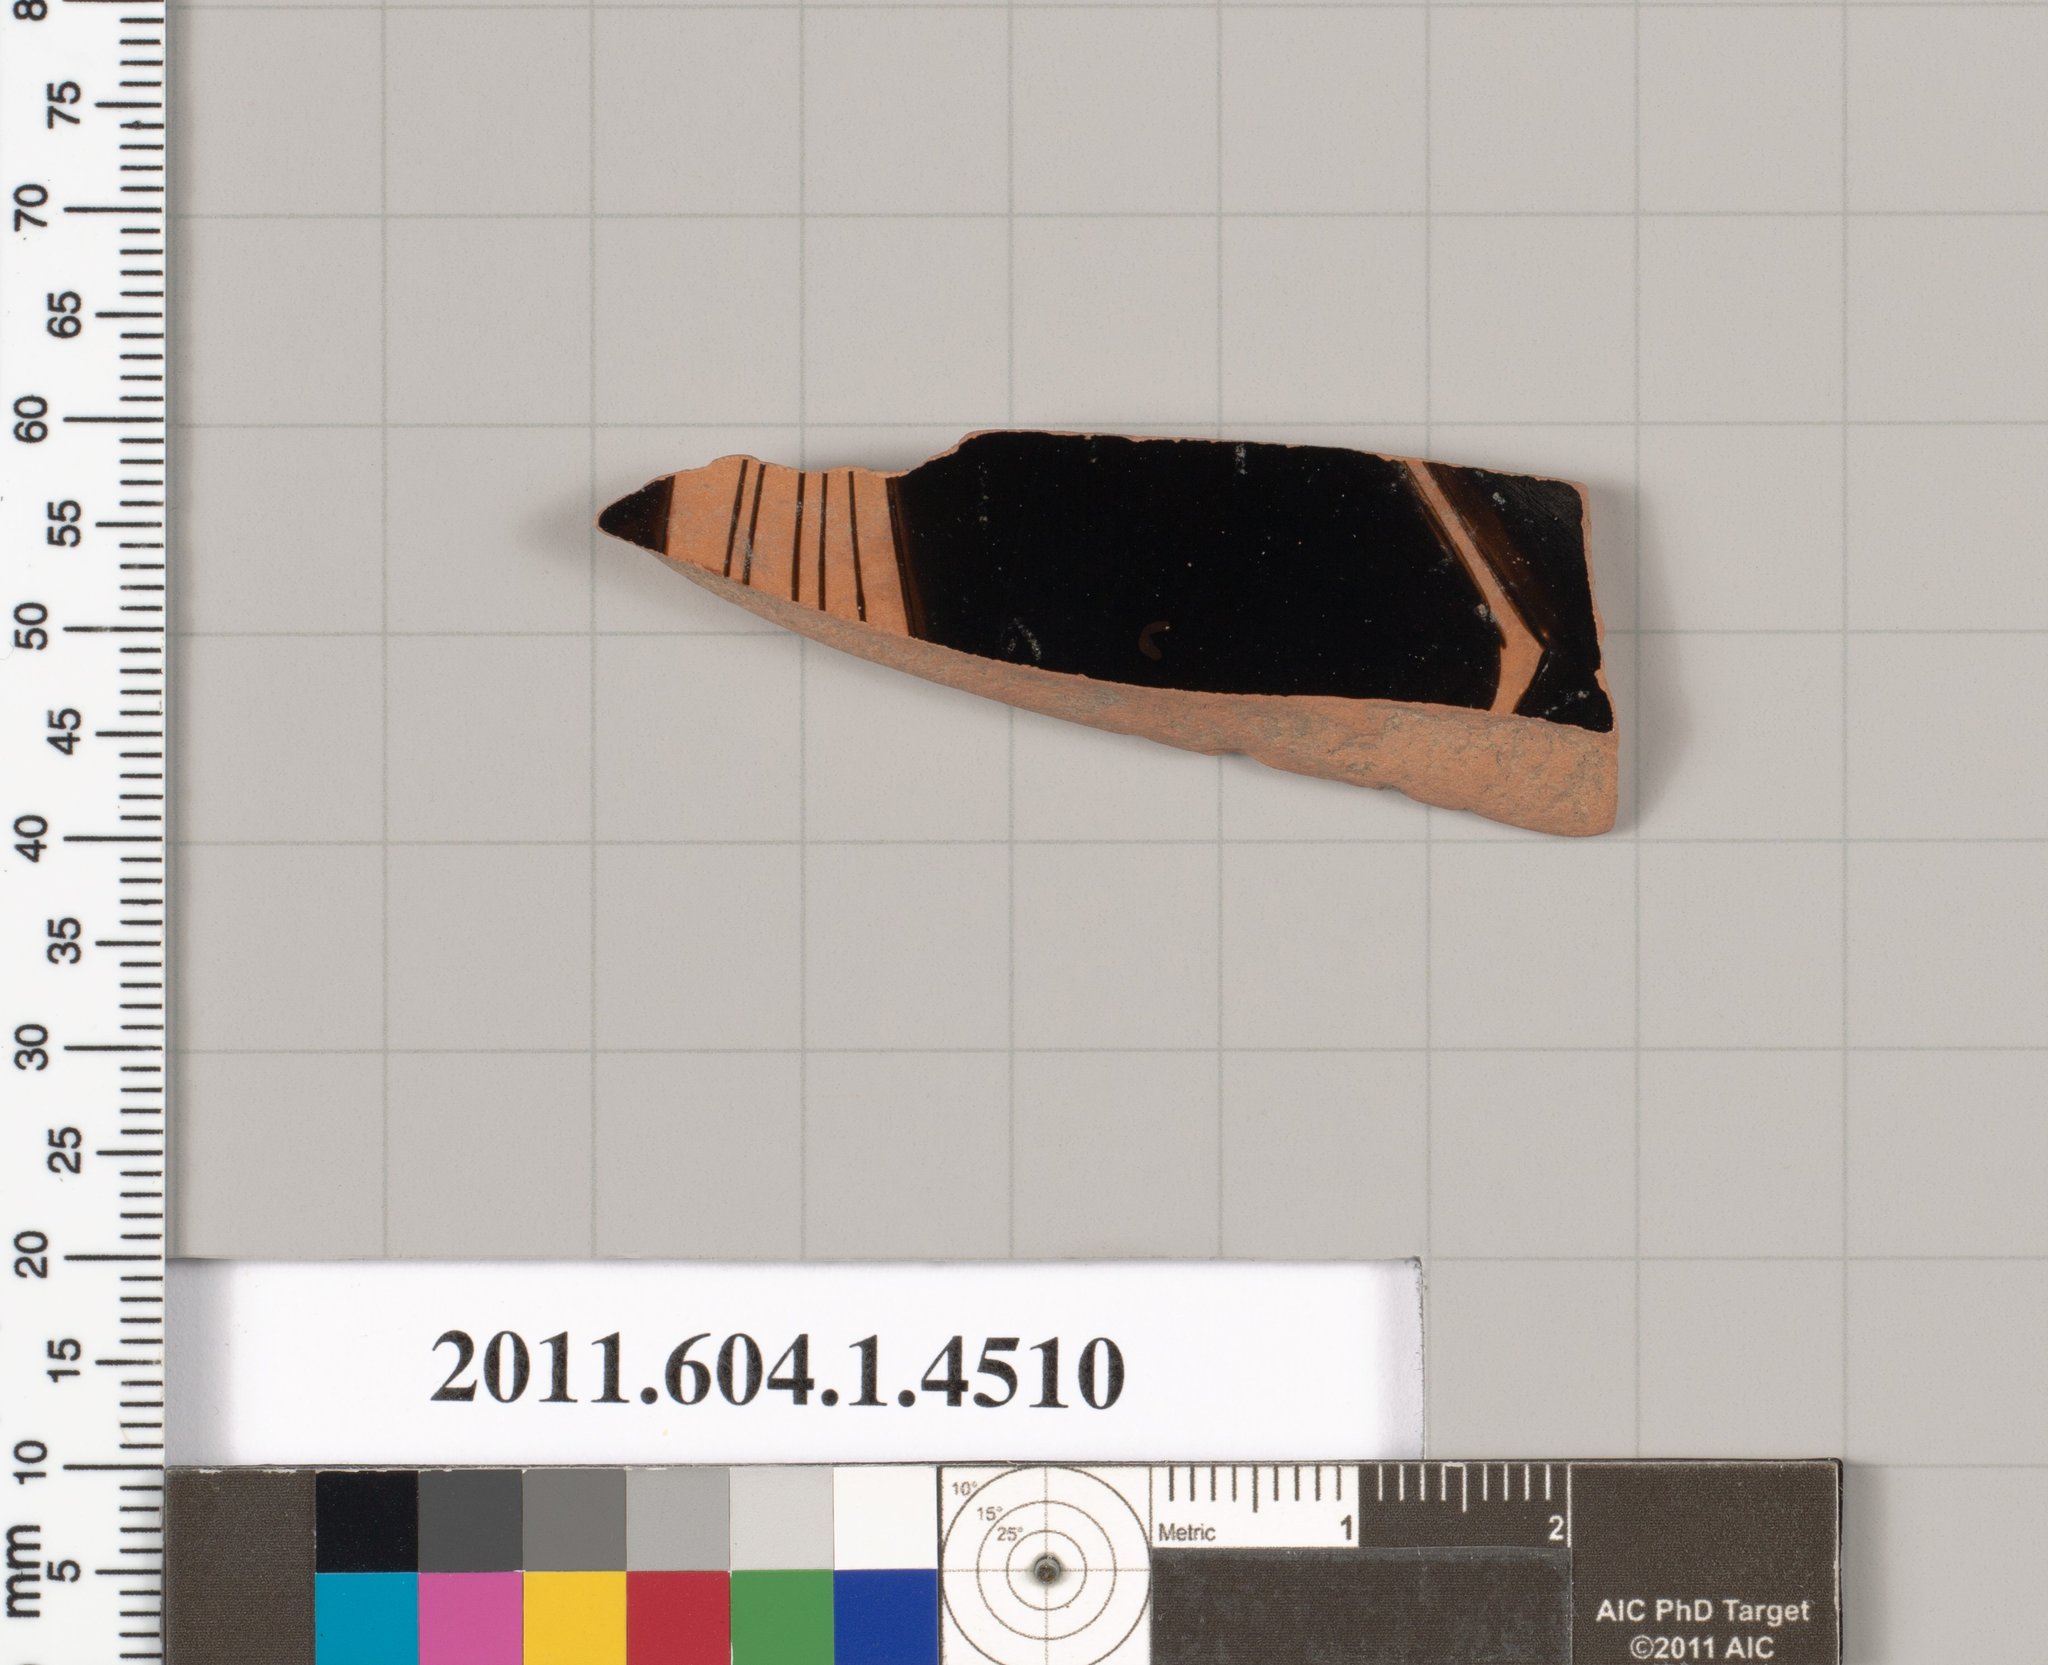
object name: kylix fragment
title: Terracotta fragment of a kylix (drinking cup)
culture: greek, attic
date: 490-470 BCE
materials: terracotta